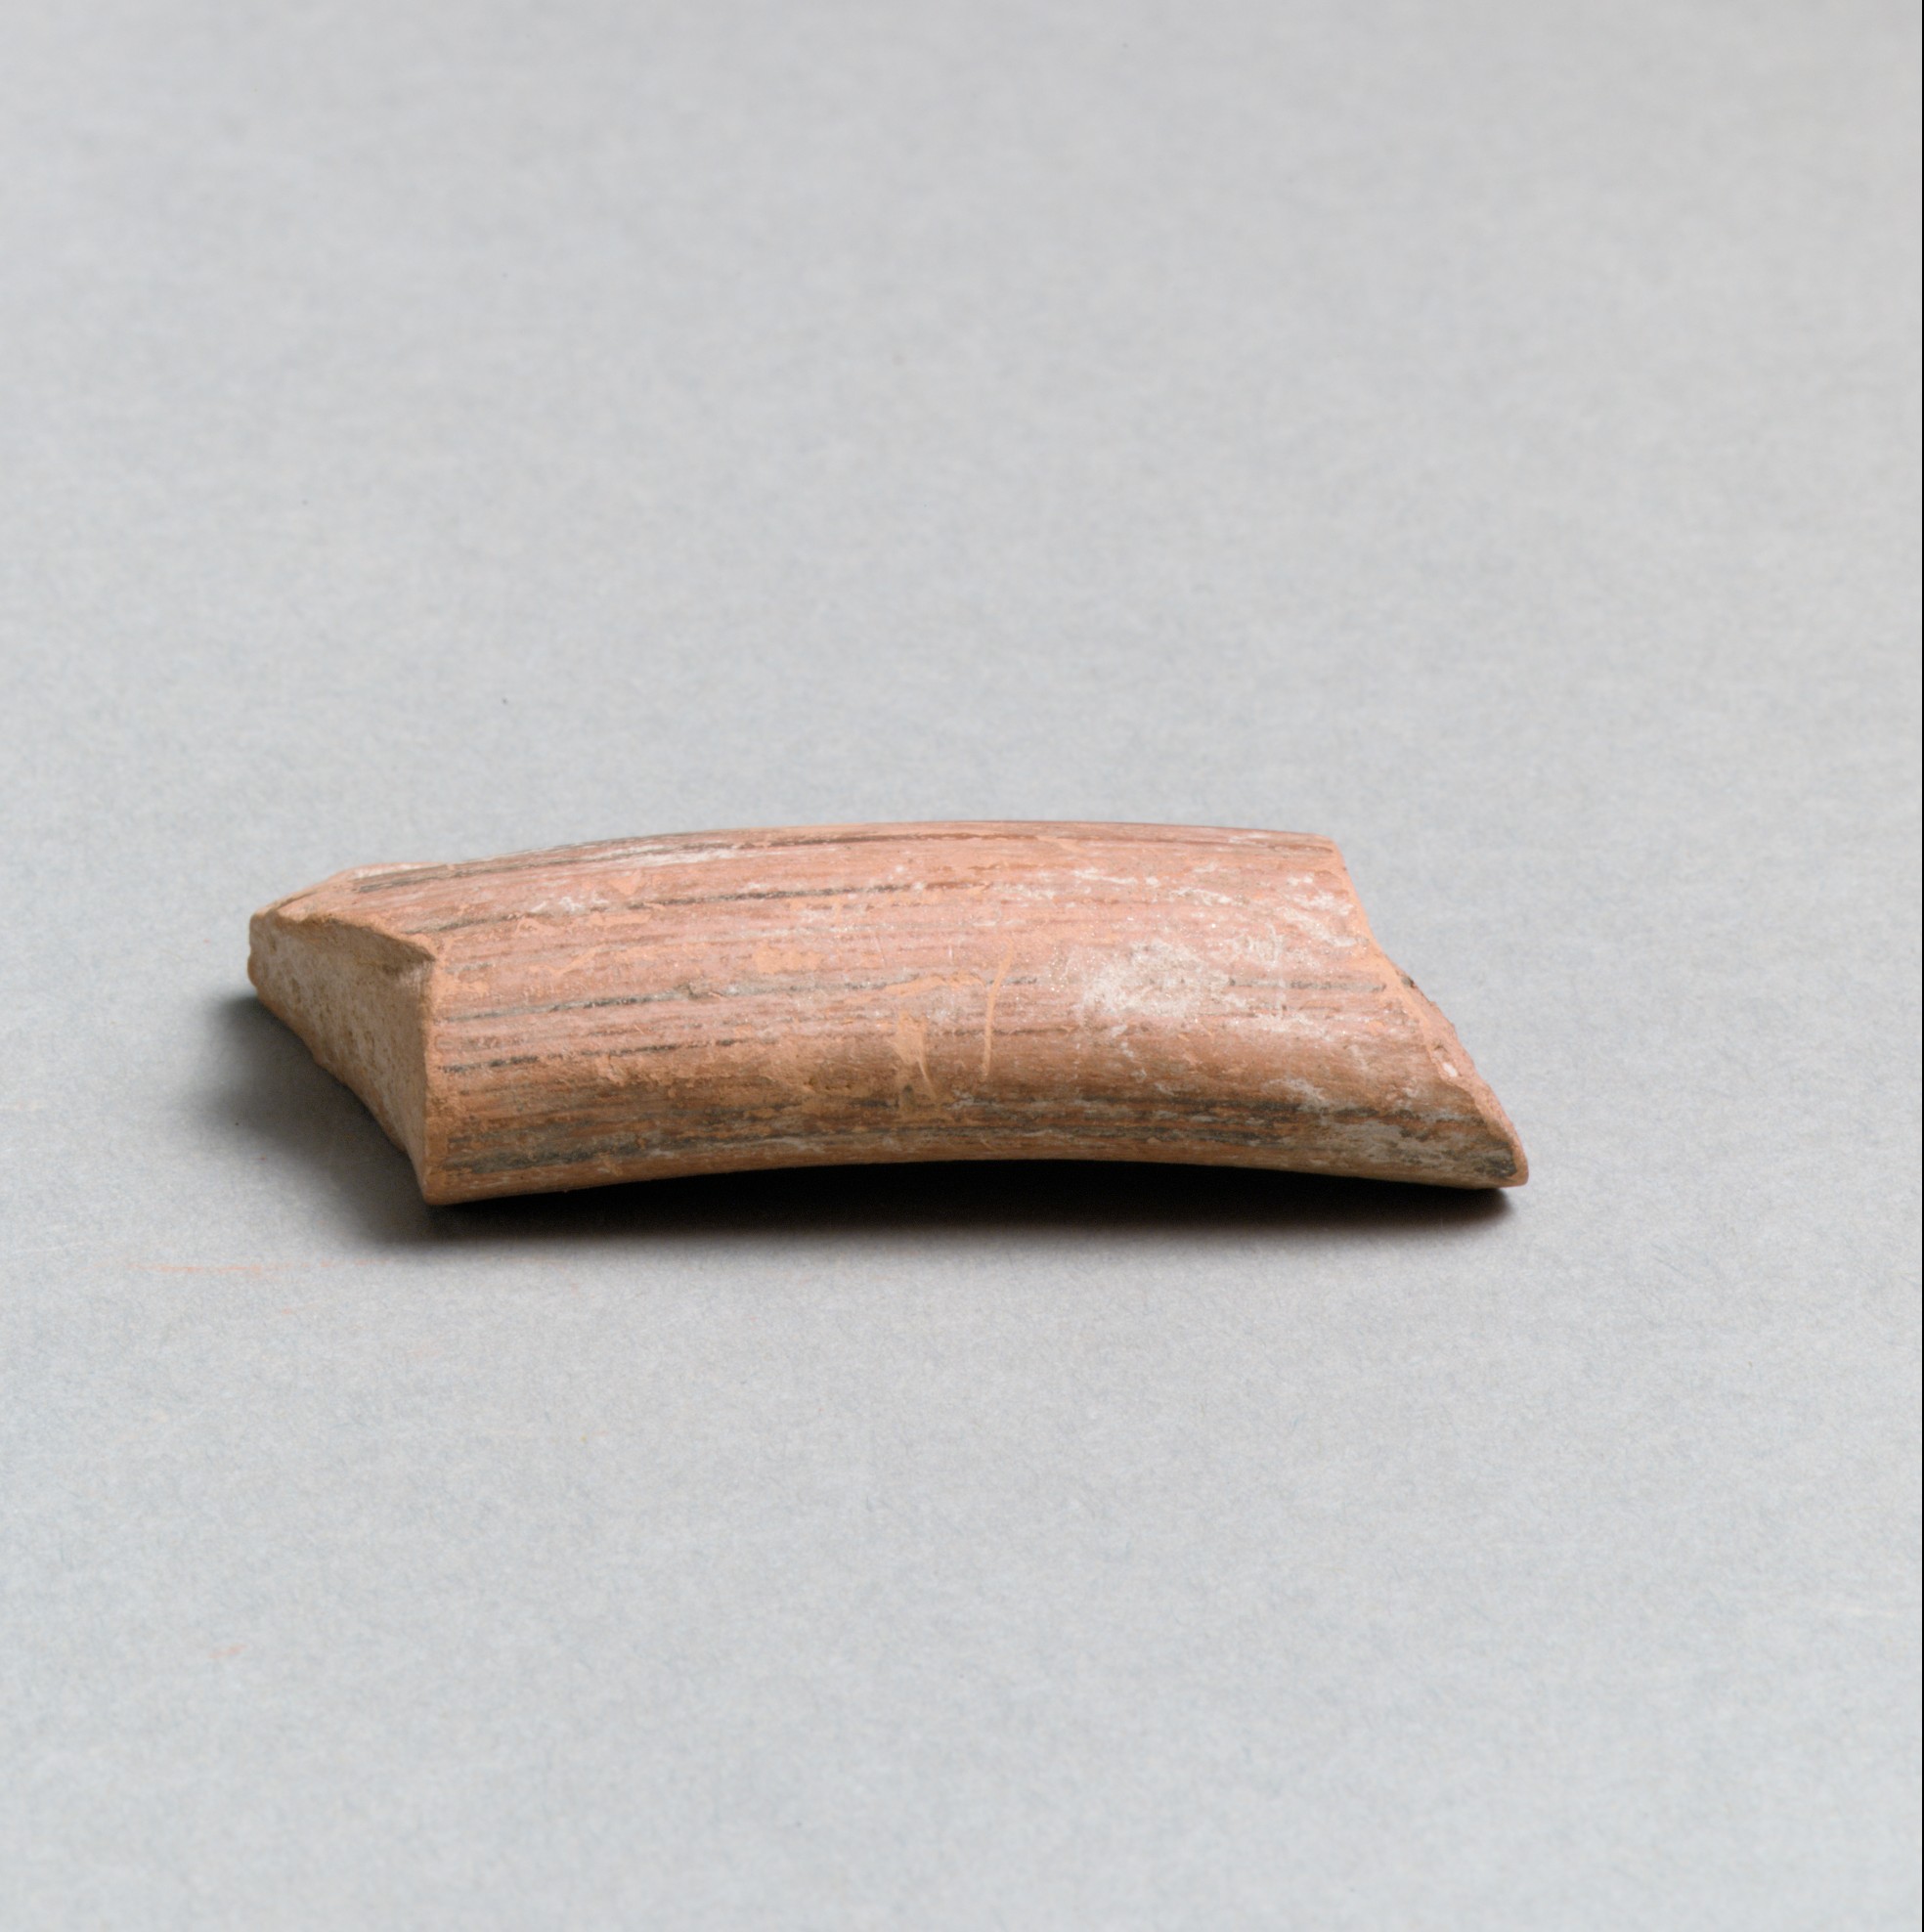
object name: vase fragment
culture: greek or lydian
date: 900-30 BCE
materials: terracotta